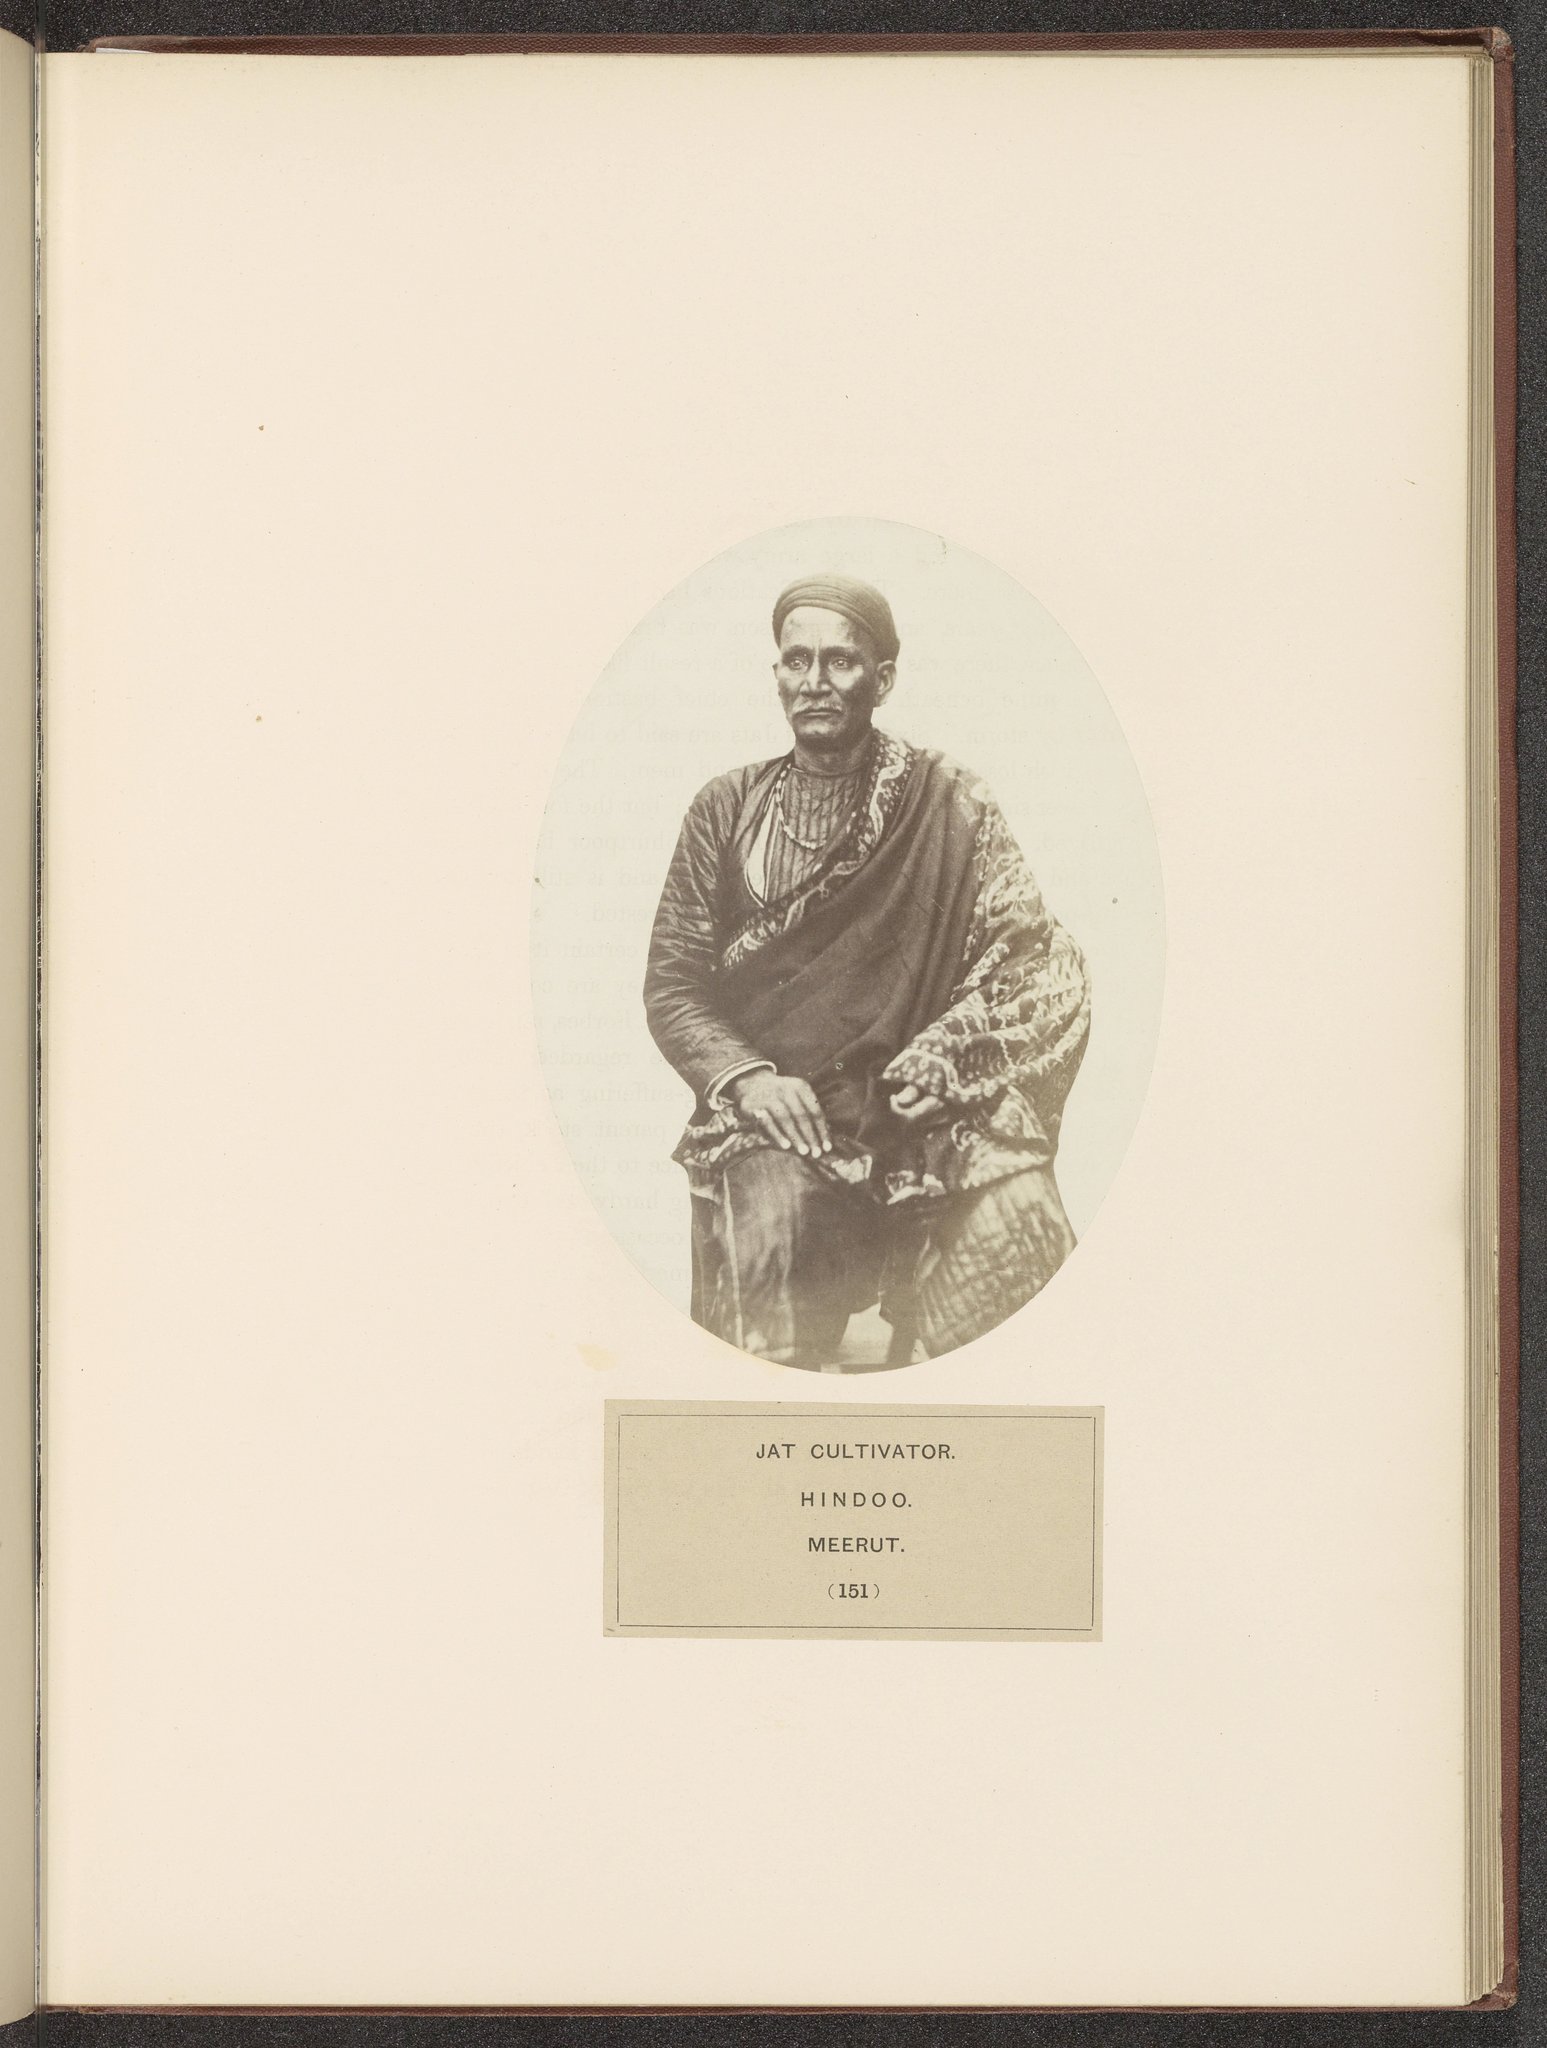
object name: page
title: Portrait of Mohur Sing, a landholder and farmer from the Jat community of Meerut, Uttar Pradesh, India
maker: Anonymous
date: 1858-1868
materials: photographic support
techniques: albumen print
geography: meerut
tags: farmers, human races; peoples; nationalities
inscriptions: number: ‘(151)’, inscription: ‘JAT CULTIVATOR./ HINDOO./ MEERUT.’